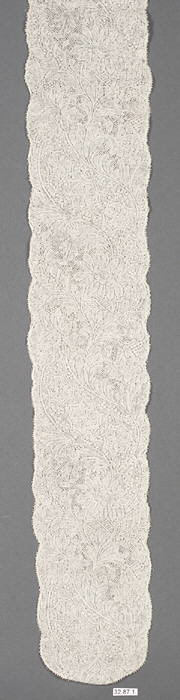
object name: barbe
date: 1701-1733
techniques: lace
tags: flowers